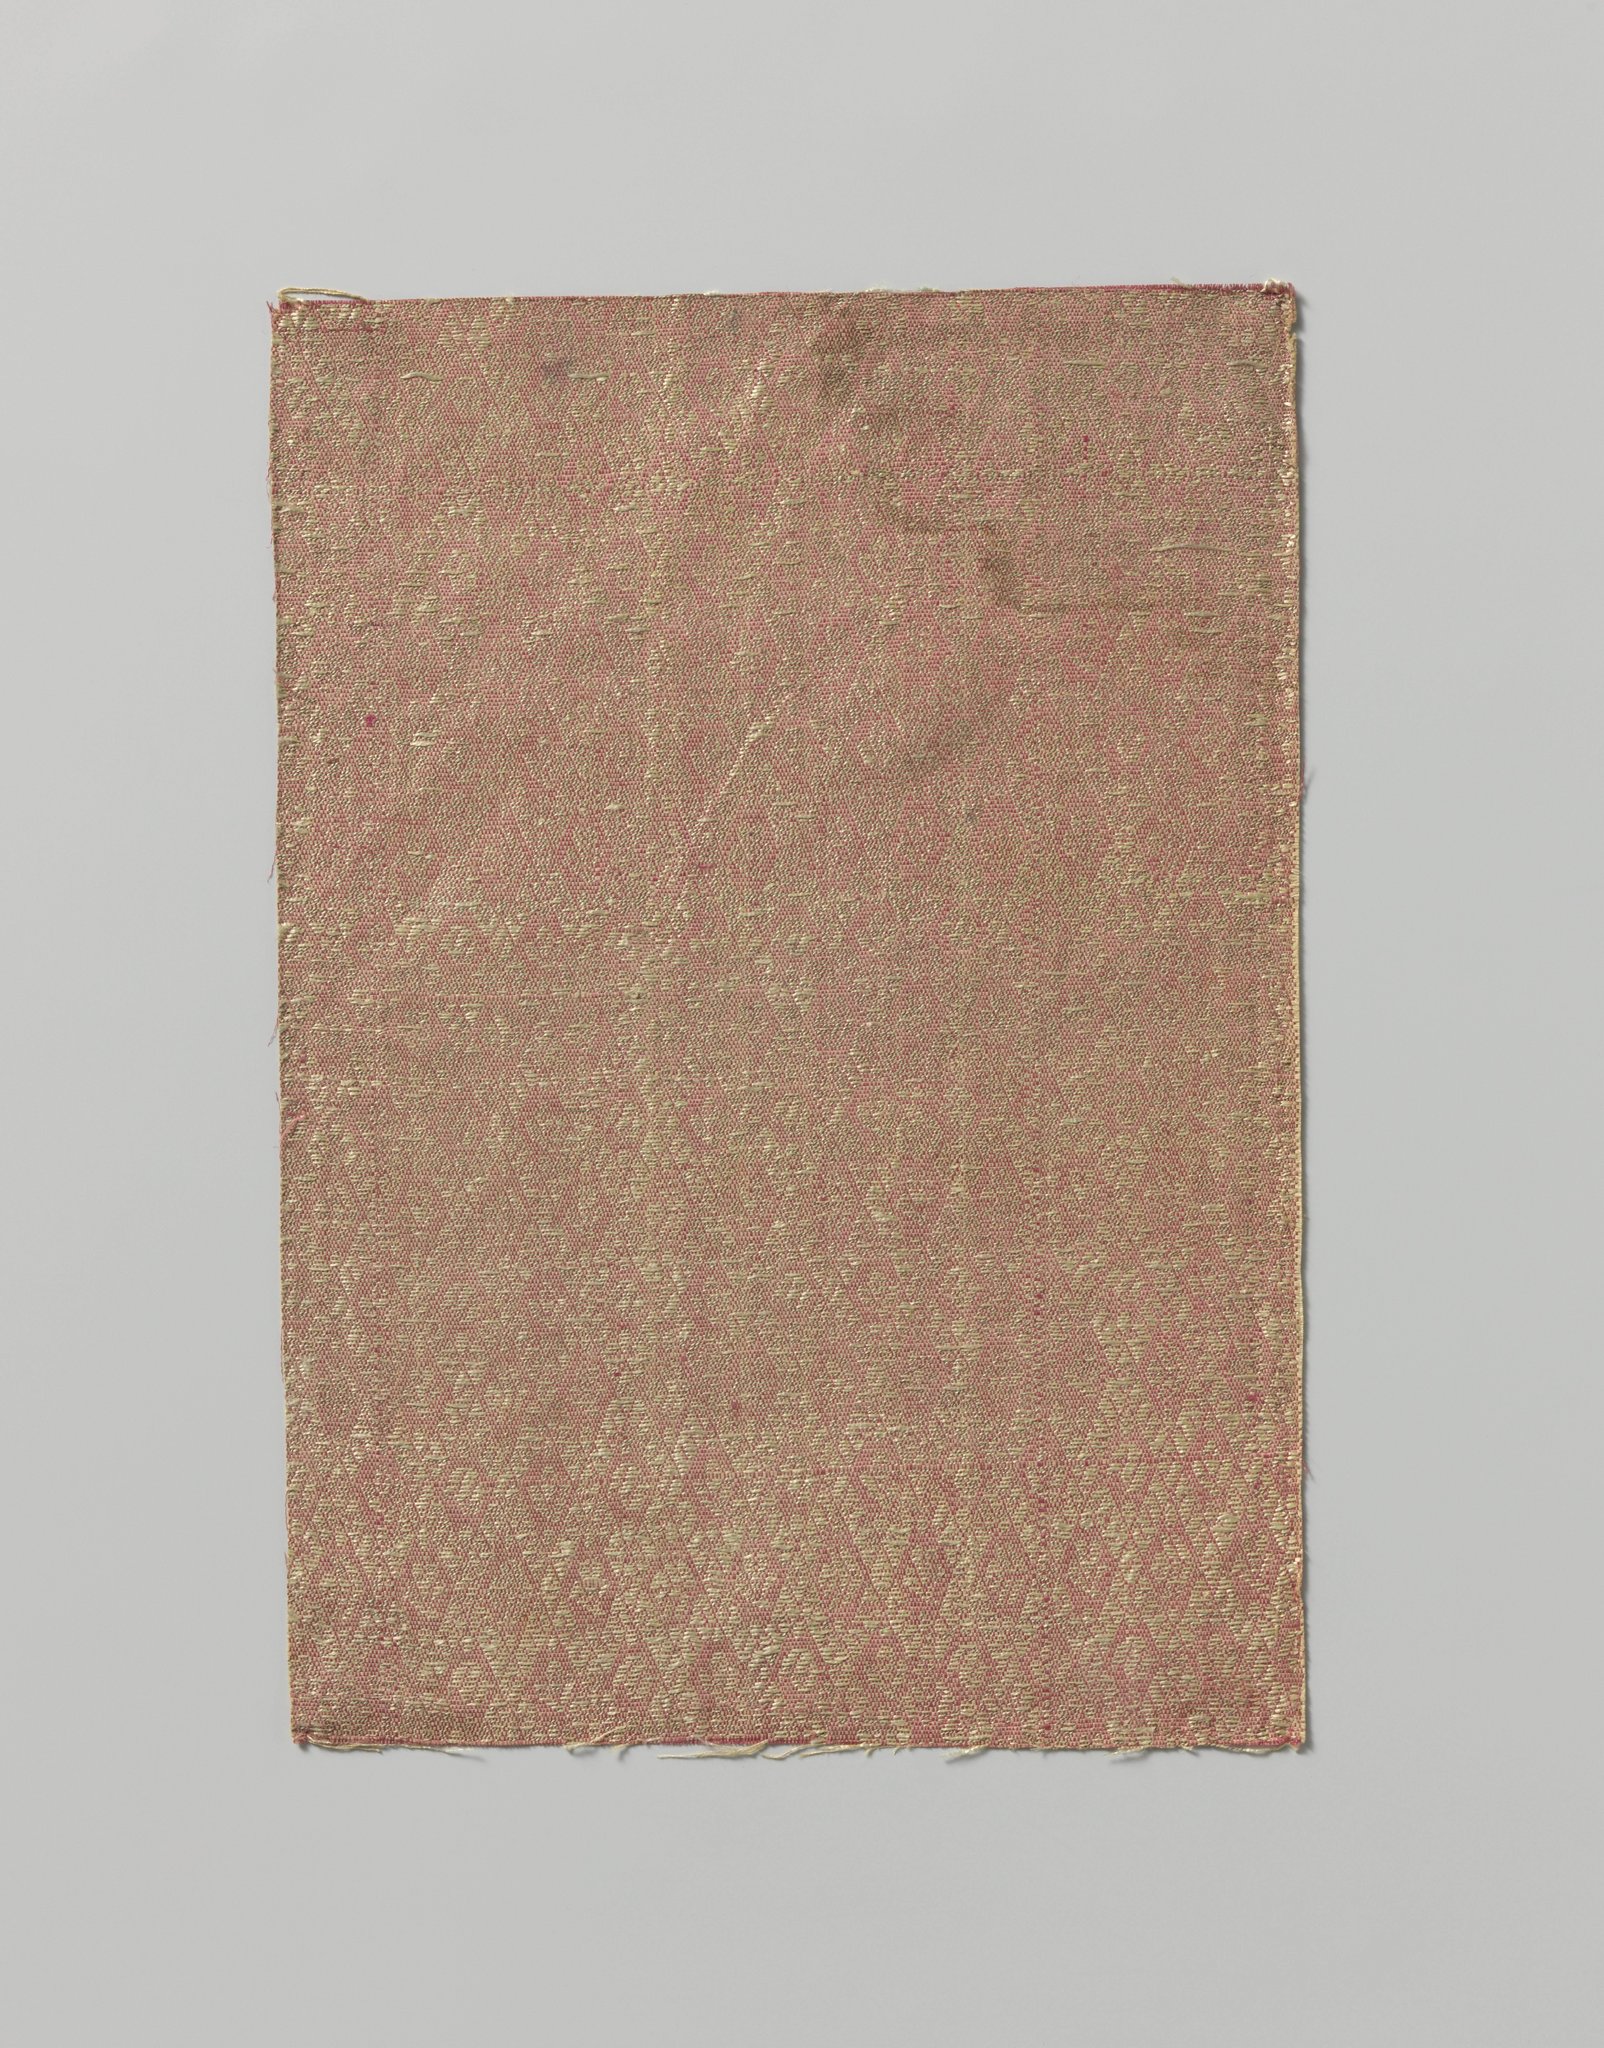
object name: silk textile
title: Fragment oosterse textiel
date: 1800-1850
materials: cotton, silk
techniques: weave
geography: india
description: Goud op rood. Patroon van netwerk van ruiten, waarin gestyl. bladeren.